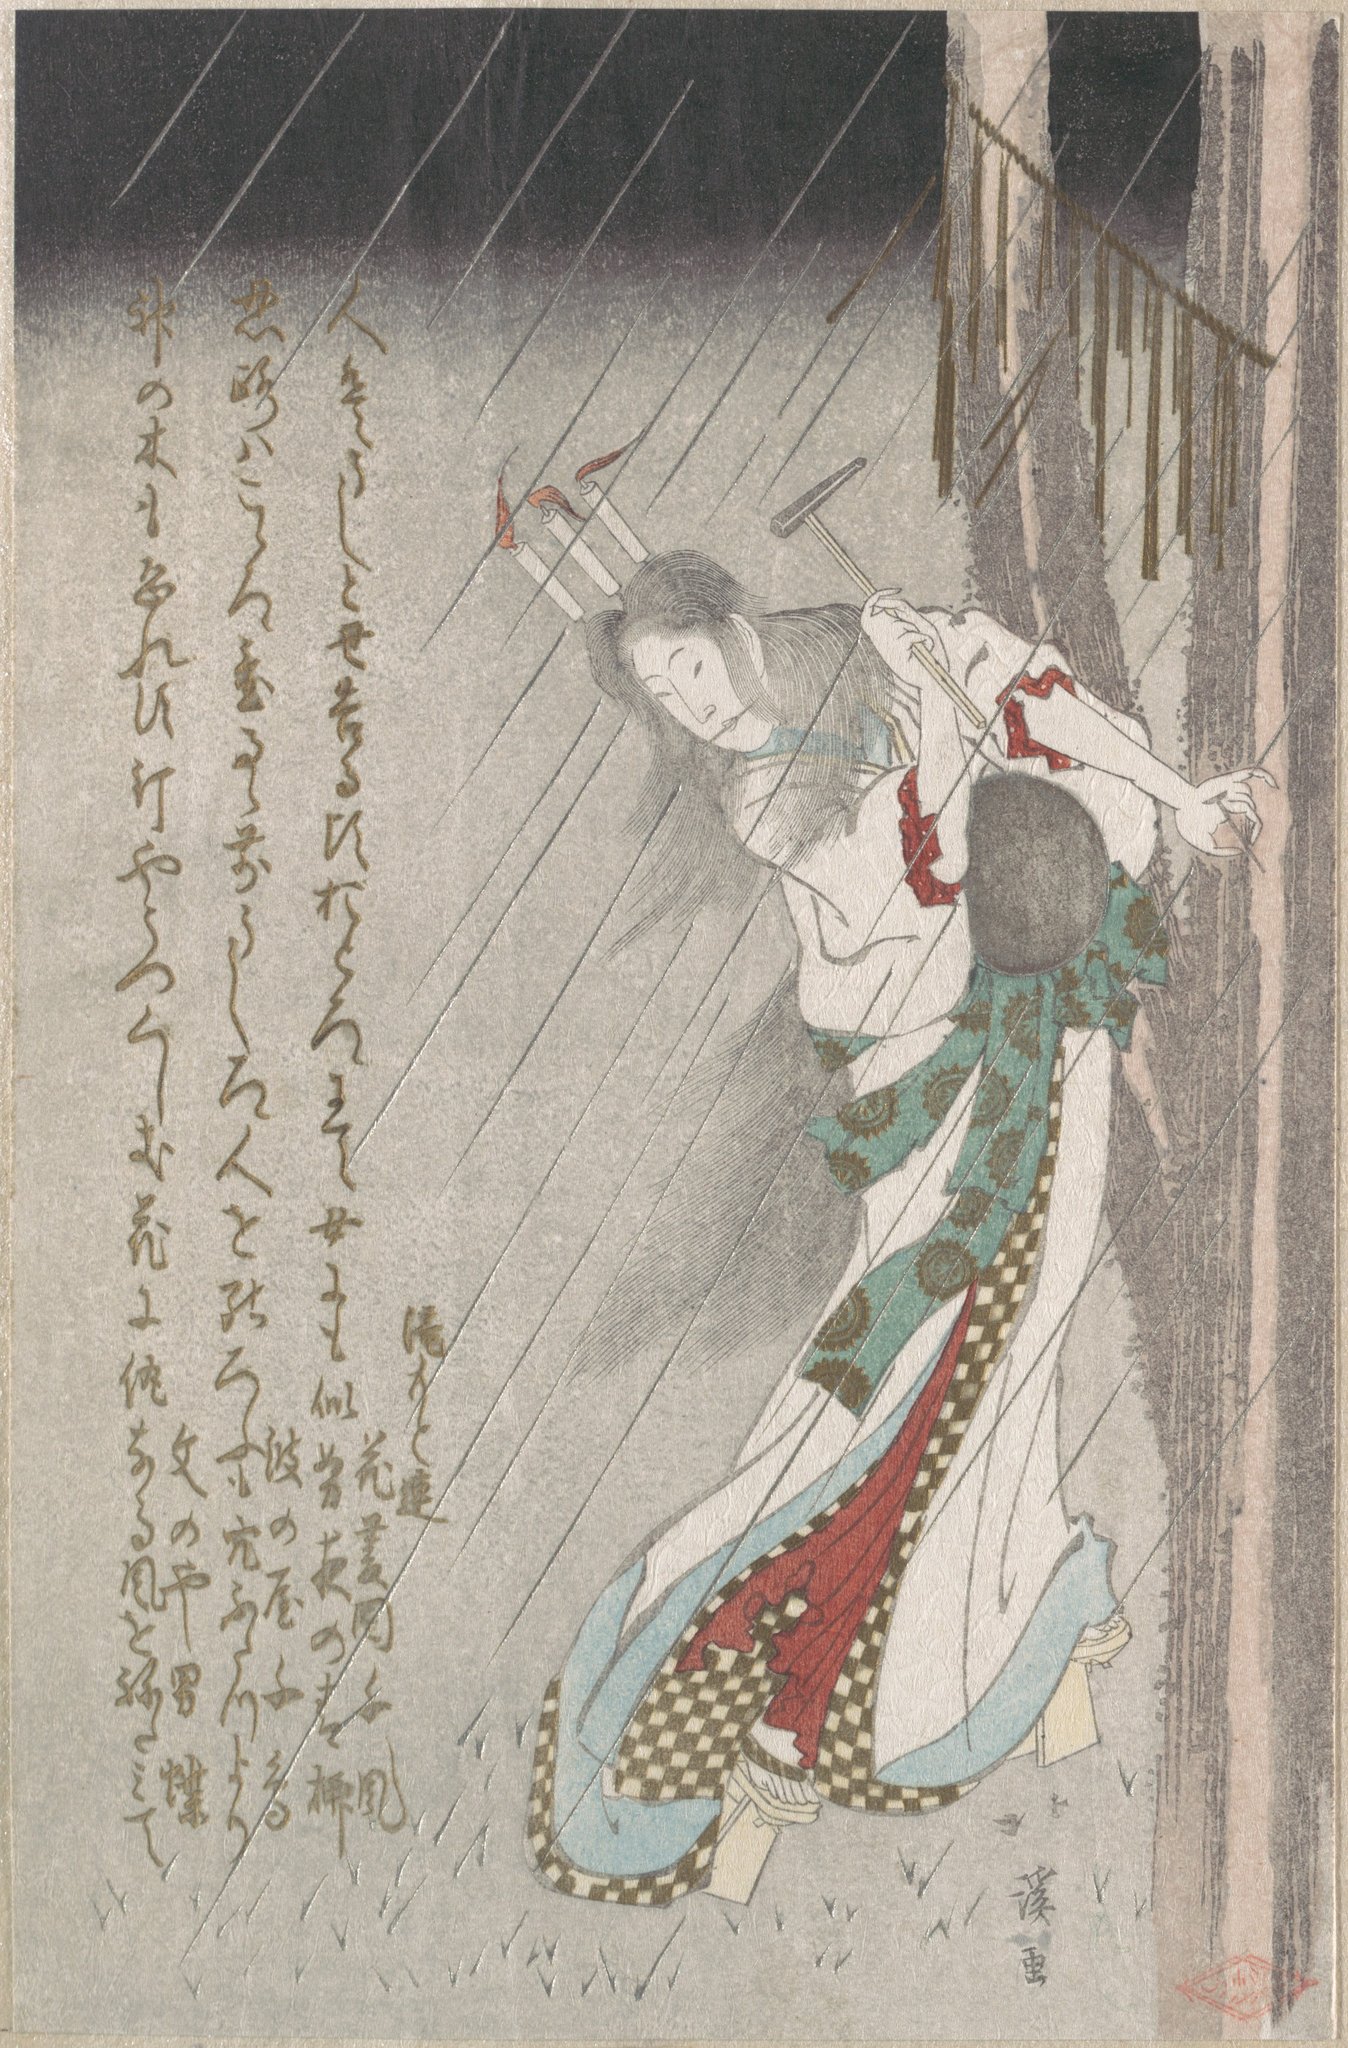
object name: print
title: Woman in the Rain at Midnight Driving a Nail into a Tree to Invoke Evil on Her Unfaithful Lover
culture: japanese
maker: totoya hokkei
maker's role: artist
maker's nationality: japanese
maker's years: 1780-1850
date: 1801-1900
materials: ink, paper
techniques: surimono, woodblock print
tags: women,rain